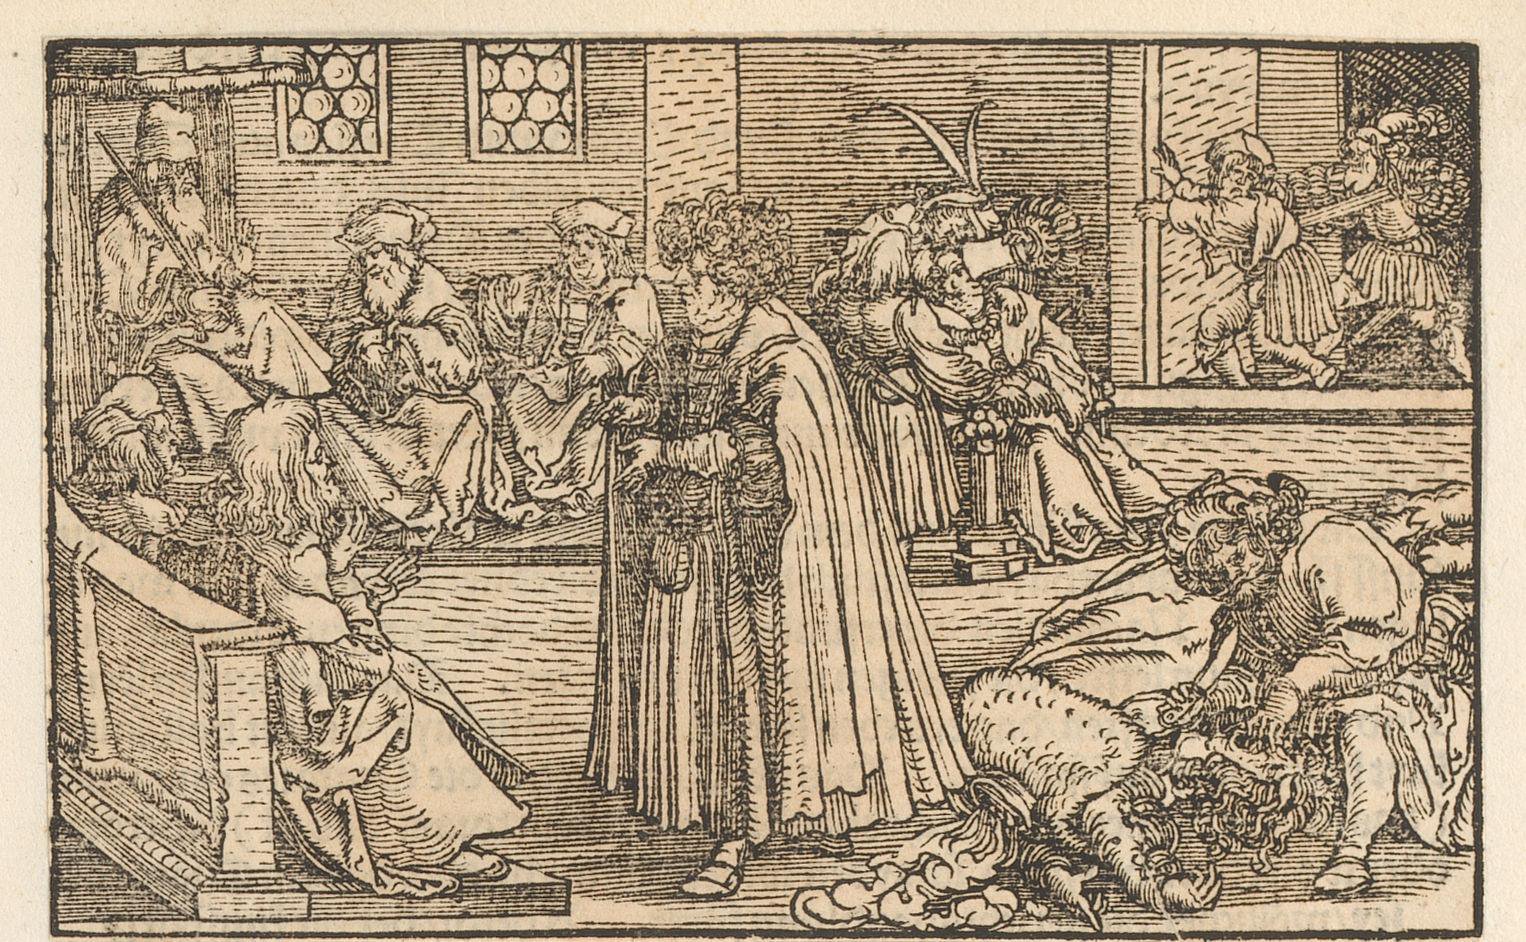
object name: print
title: Man in een rechtbank terwijl drie moorden worden gepleegd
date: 1514-1532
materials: paper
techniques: letterpress printing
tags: violent death by cleaving and striking weapons, violent death by poisoned cup, administration of justice, trial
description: Deze prent is gebruikt in: Petrarca, Francesco. Von der Artzney bayder Glück, des guten und widerwertigen: unnd weß sich ain yeder inn Gelück und Unglück halten sol (...). Augsburg: Heinrich Steiner, 1532. Deze uitgave is ook bekend onder de titel 'Trostspiegel in Glück und Unglück'. Deze prent is ook gebruikt in: Cicero, Marcus Tulius. Officia M.T.C. Ein Buch so Marcus Tullius Cicero der Römer zu seynem (...). [Vertaald uit het Latijn door] Johann von Schwarzenberg. Augsburg: Heinrich Steiner, 1531.